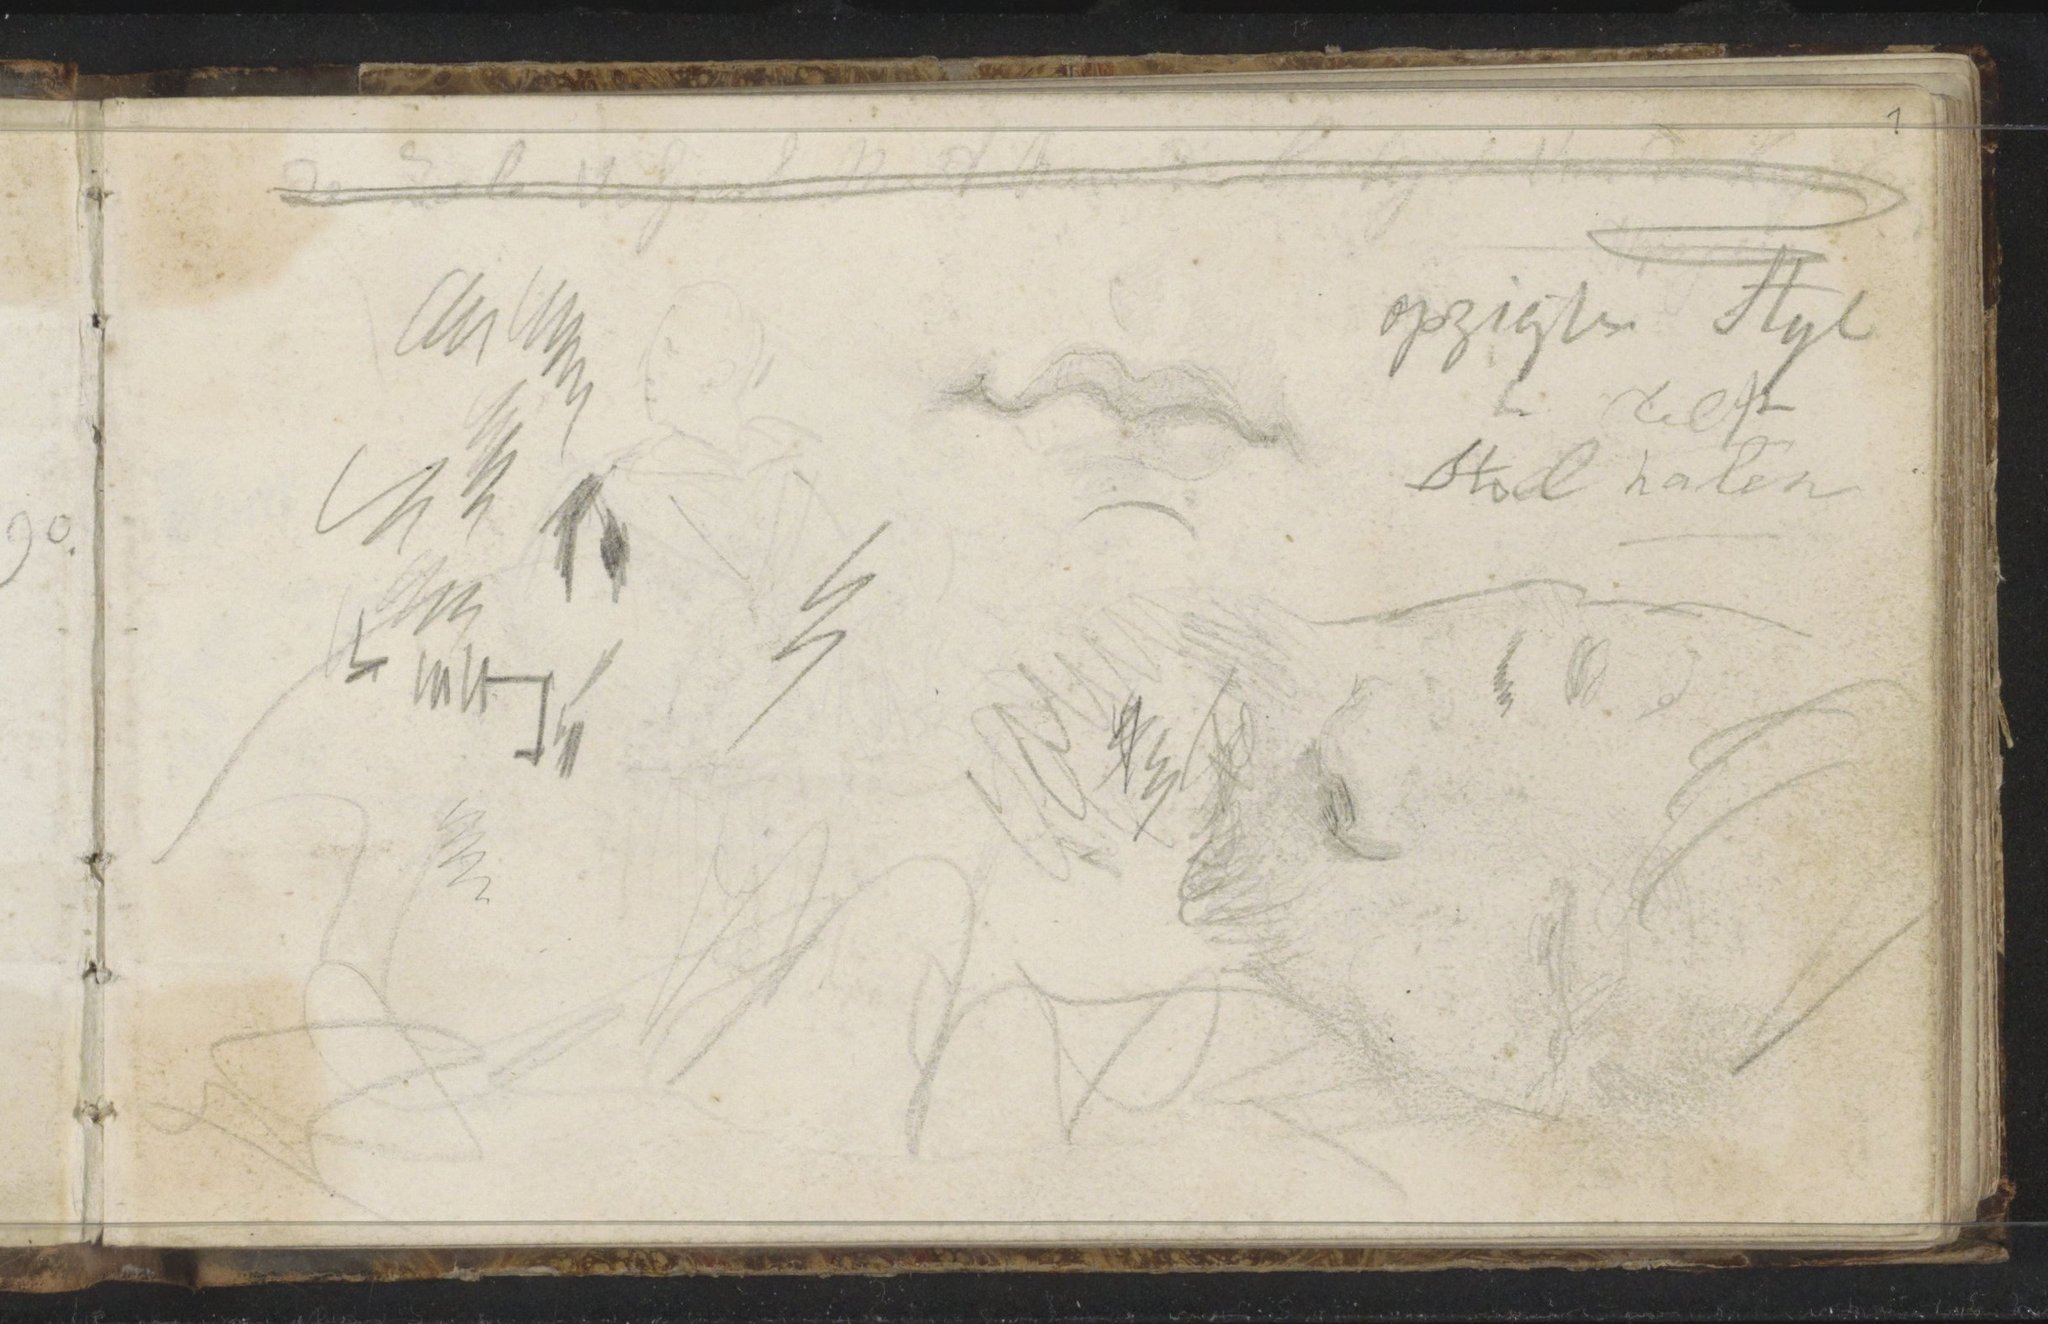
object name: sketchbook leaf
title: Gezicht van een man en een kop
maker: willem hendrik schmidt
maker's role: draughtsman, painter, print maker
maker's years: 1809-1849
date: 1819-1849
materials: paper, pencil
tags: face, head (human)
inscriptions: annotation: ‘opzigter stijl/ [...] helft/ stoel halen’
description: Blad 1 recto uit een schetsboek met 60 bladen.